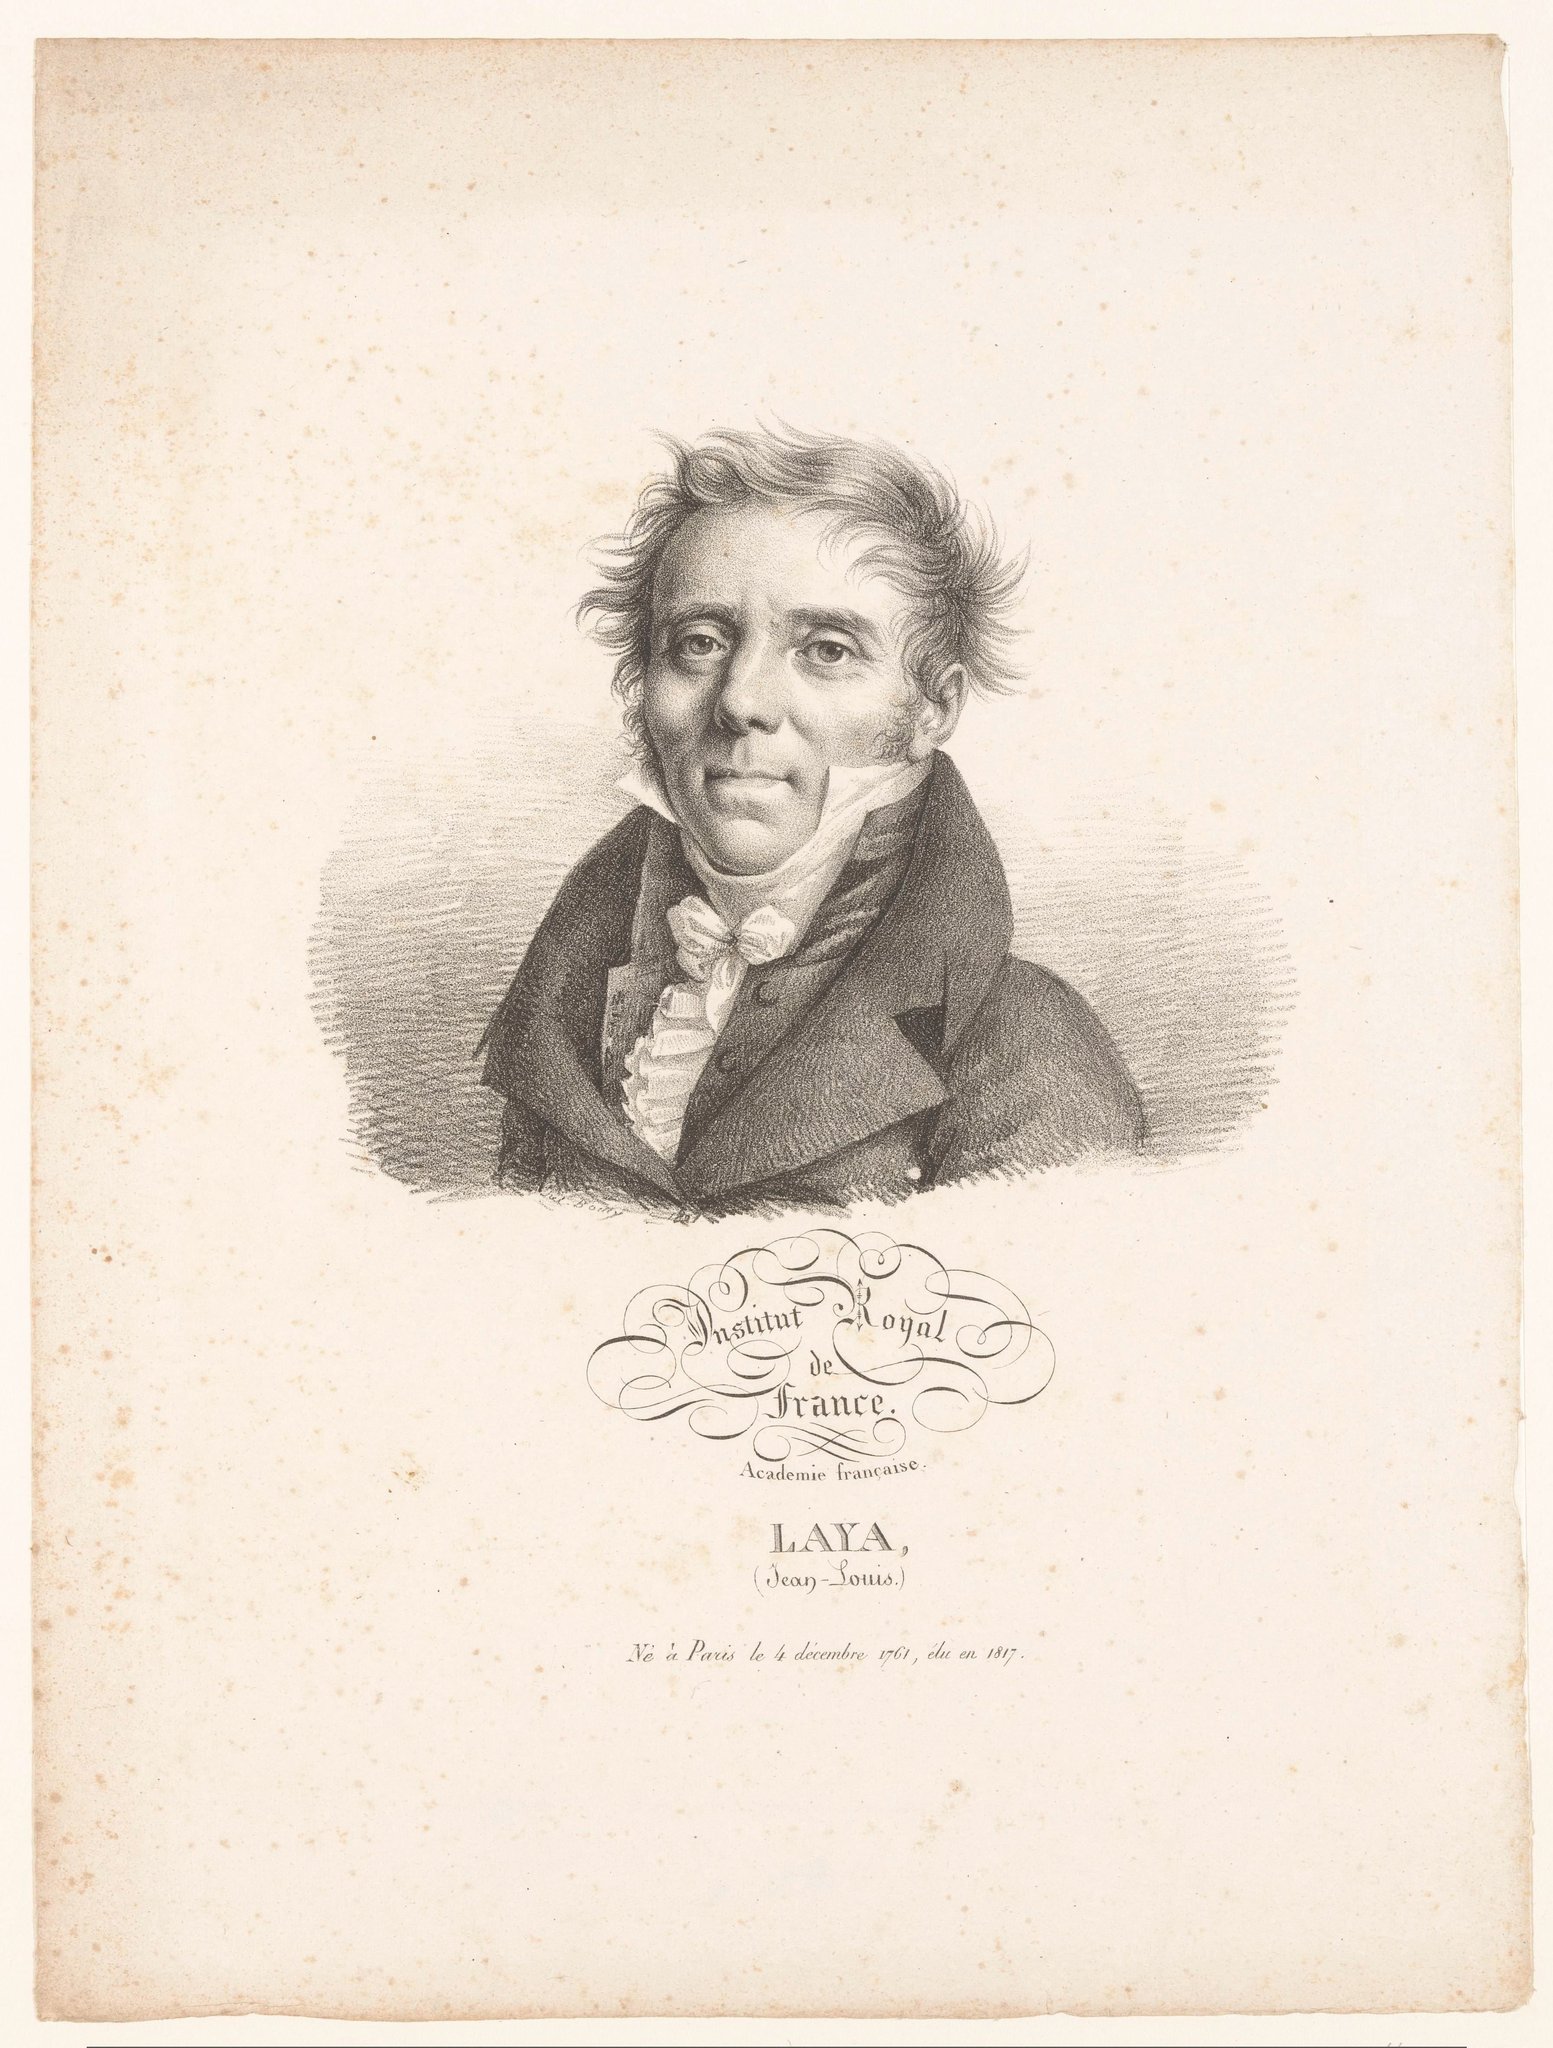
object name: print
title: Laya, Jean-Louis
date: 1821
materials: paper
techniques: lithograph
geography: paris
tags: paris, historical persons, portrait of a writer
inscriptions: collector's mark: Lugt 2228a